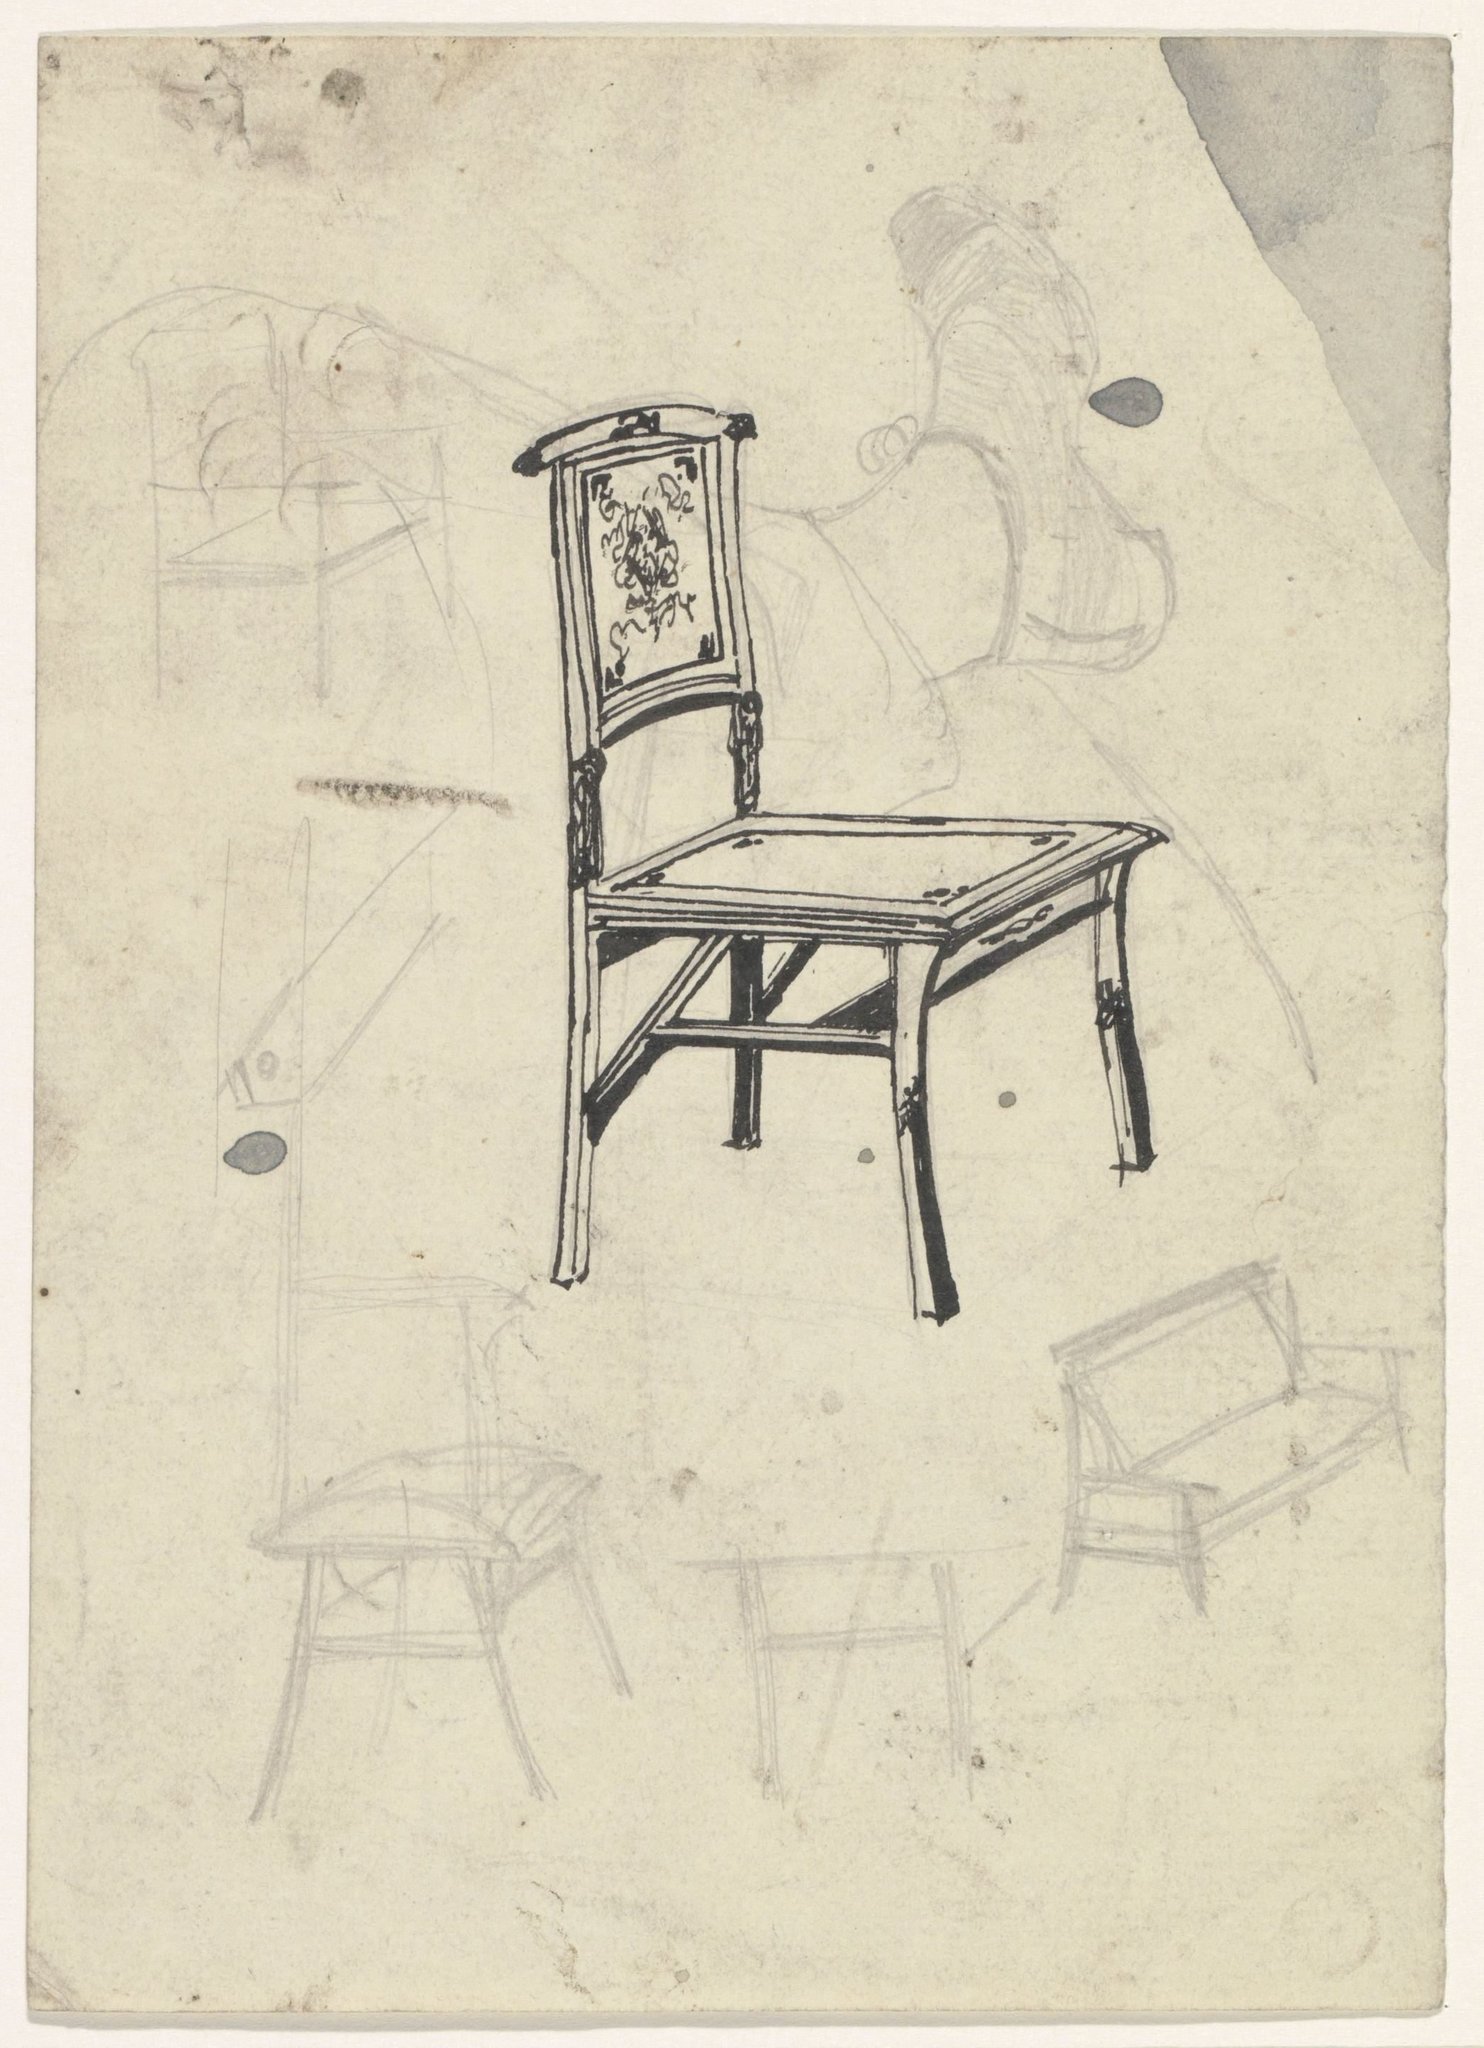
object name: drawing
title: Ontwerp voor een stoel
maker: carel adolph lion cachet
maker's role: draughtsman, print maker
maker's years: 1864-1945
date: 1874-1945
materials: ink, paper, pencil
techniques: pen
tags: chair